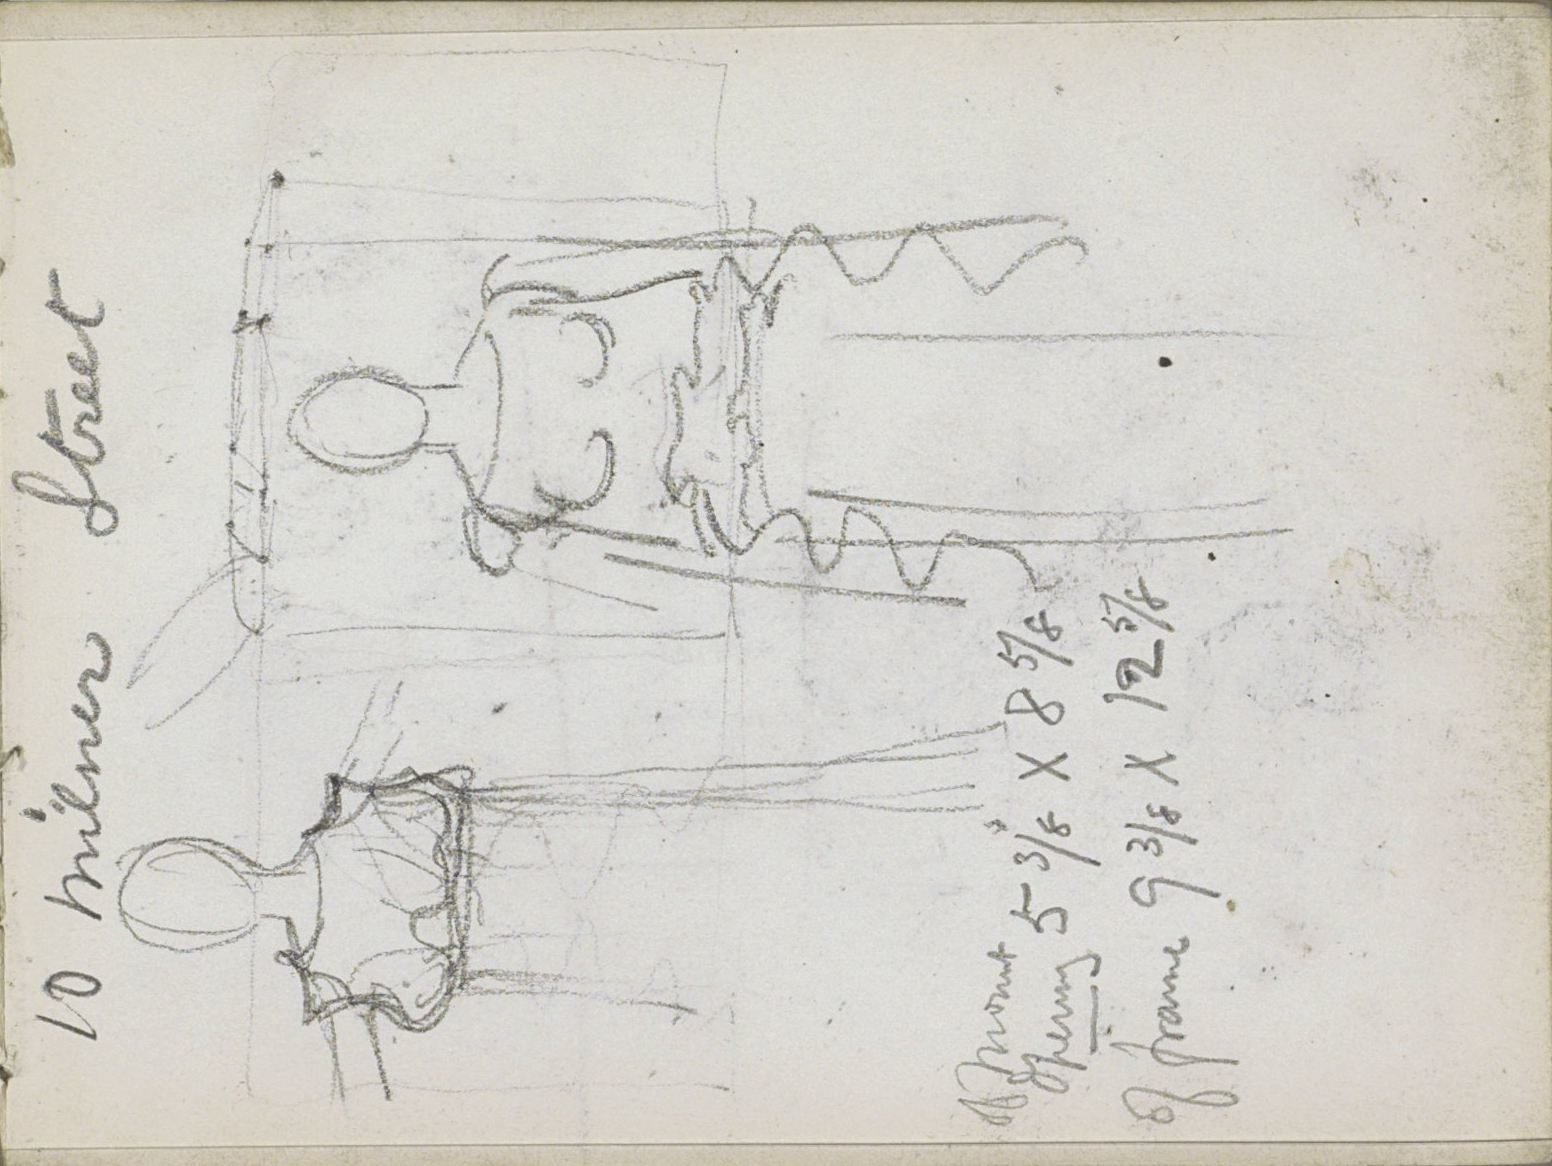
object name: sketchbook leaf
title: Twee vrouwfiguren, mogelijk paspoppen, in jurken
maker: george clausen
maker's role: draughtsman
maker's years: 1852-1912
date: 1874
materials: paper, pencil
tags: adult woman, dress, gown (+ women's clothes), model, mannequin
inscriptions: annotation: ‘10 milner Street/ [...] mount/ opening 5 3/8 x 8 5/8/ of frame 9 3/8 x 12 5/8’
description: Blad 4 recto uit een schetsboek met 37 bladen.